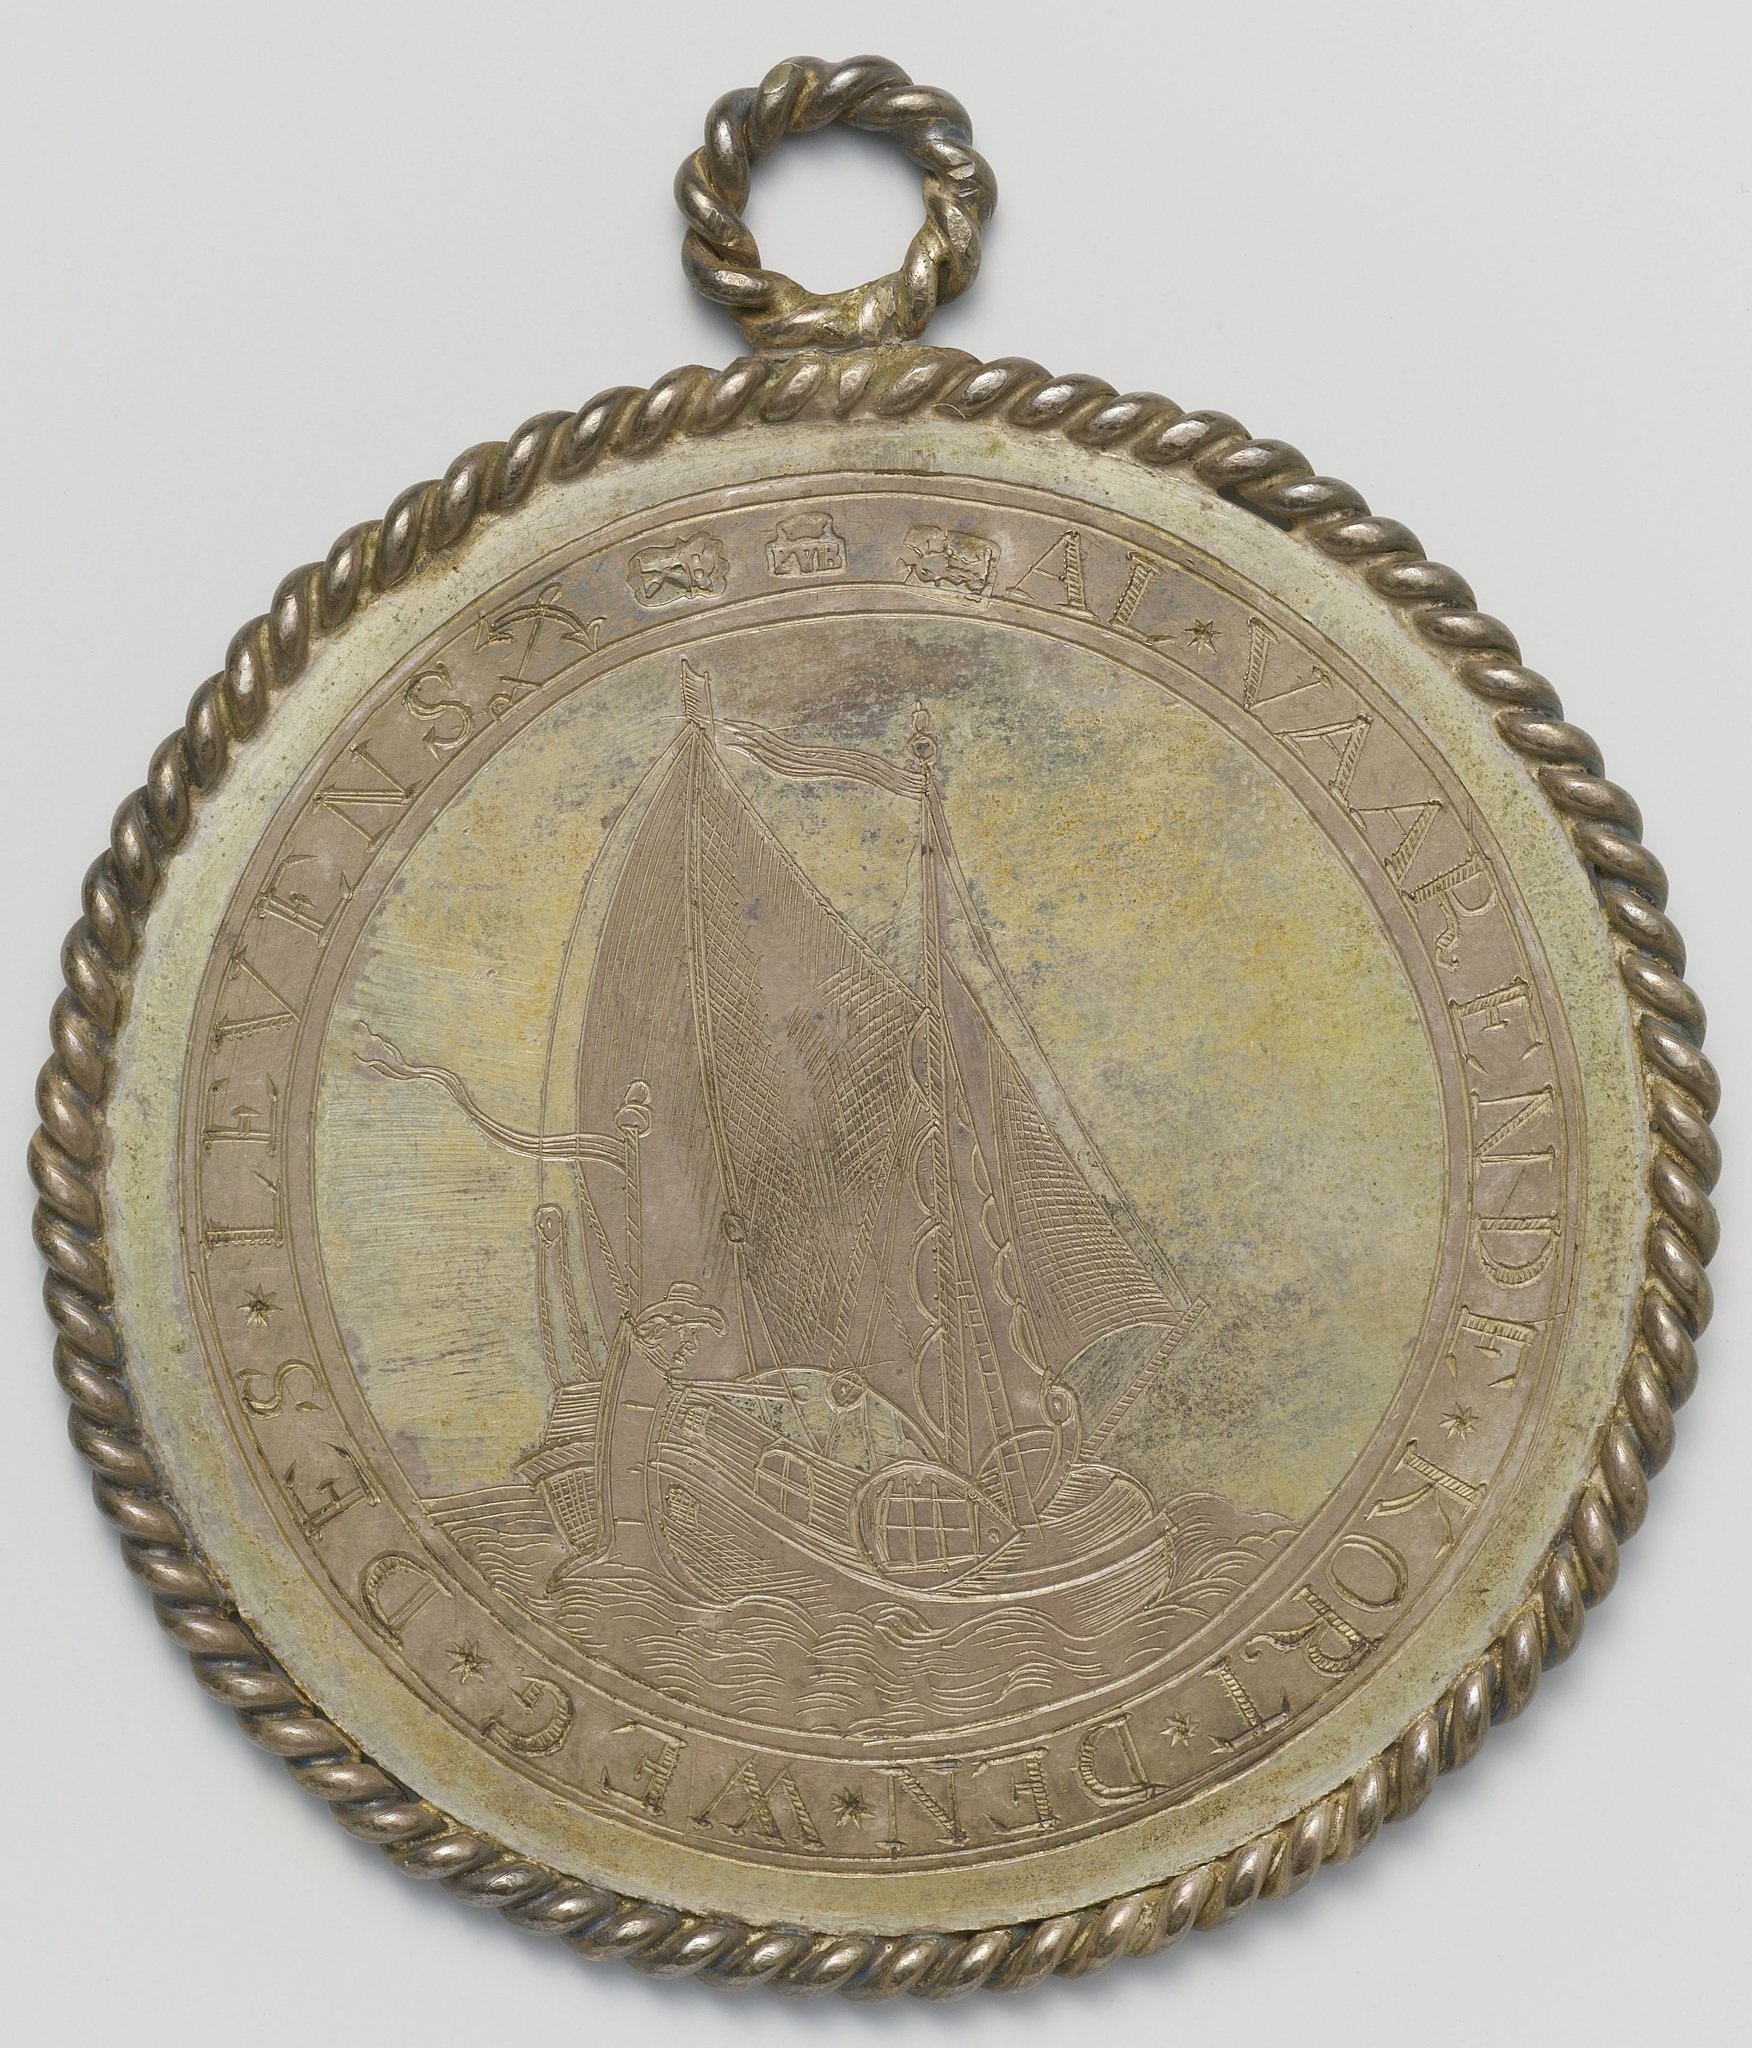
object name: medal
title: Den Bosch, Bargemen’s Guild, Honoring the Head Deans Claude Antoine Lormier and Willem Cornelis Ackersdyck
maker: paulus van beugen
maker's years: 1765-1814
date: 1783-1784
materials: silver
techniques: casting, engraving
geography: den bosch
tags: den bosch